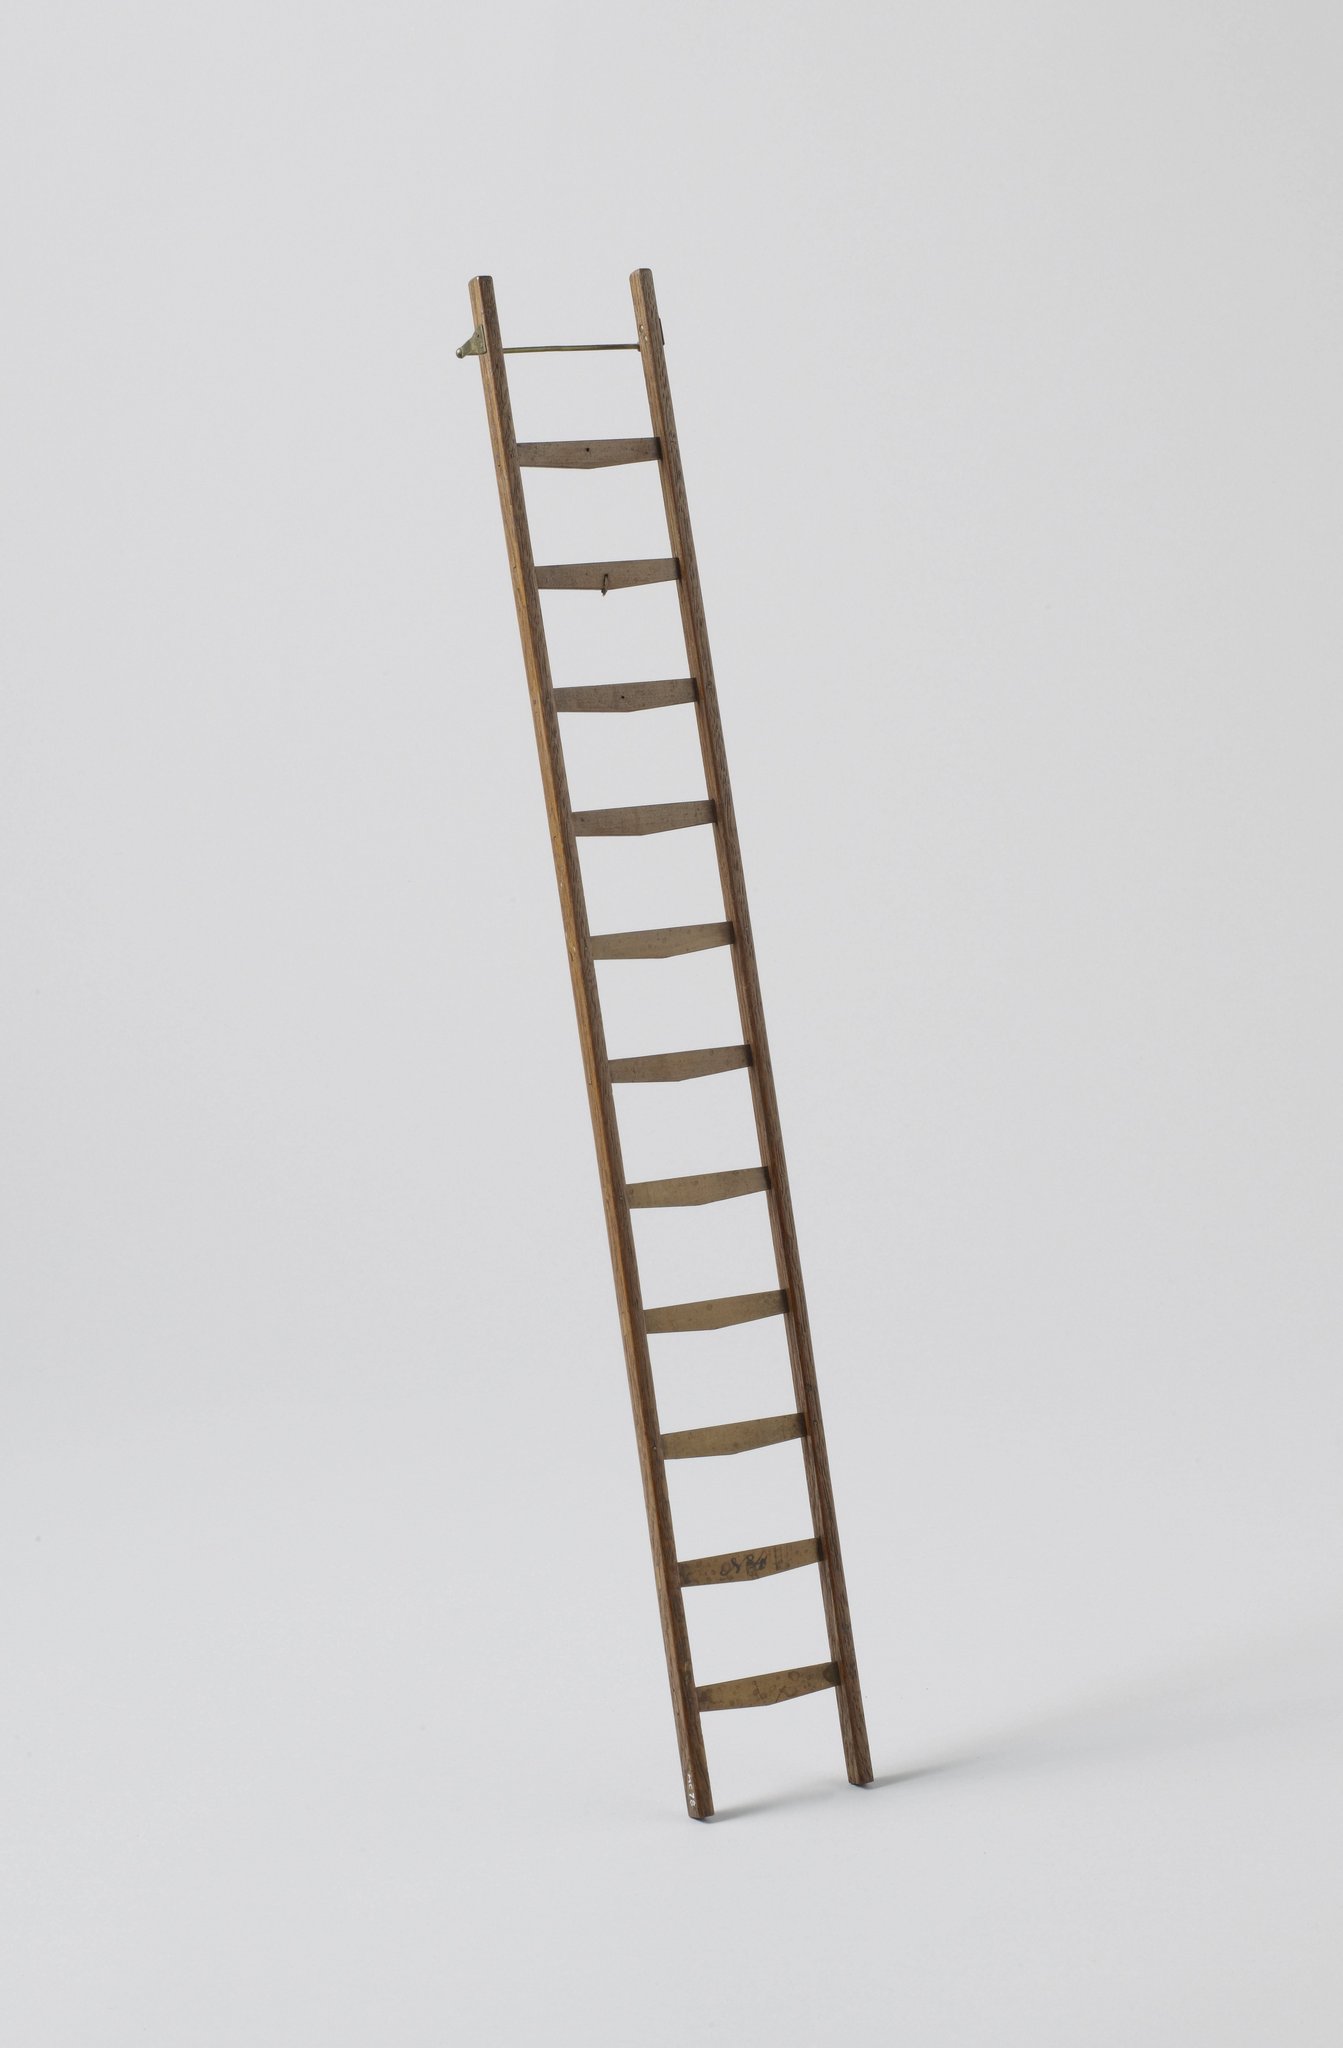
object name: demonstration model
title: Model of a Ladder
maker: petrus van der loo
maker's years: 1806-1864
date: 1850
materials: brass, wood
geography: the hague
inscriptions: inscription, on a rung: ‘No 4’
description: Maar één van de drie delen van deze ladder is teruggevonden. De bovenste twee delen zouden eerst tegelijk met de hand uitgeschoven moeten worden, waarna het bovenste stuk met een spil verder wordt uitgeschoven.